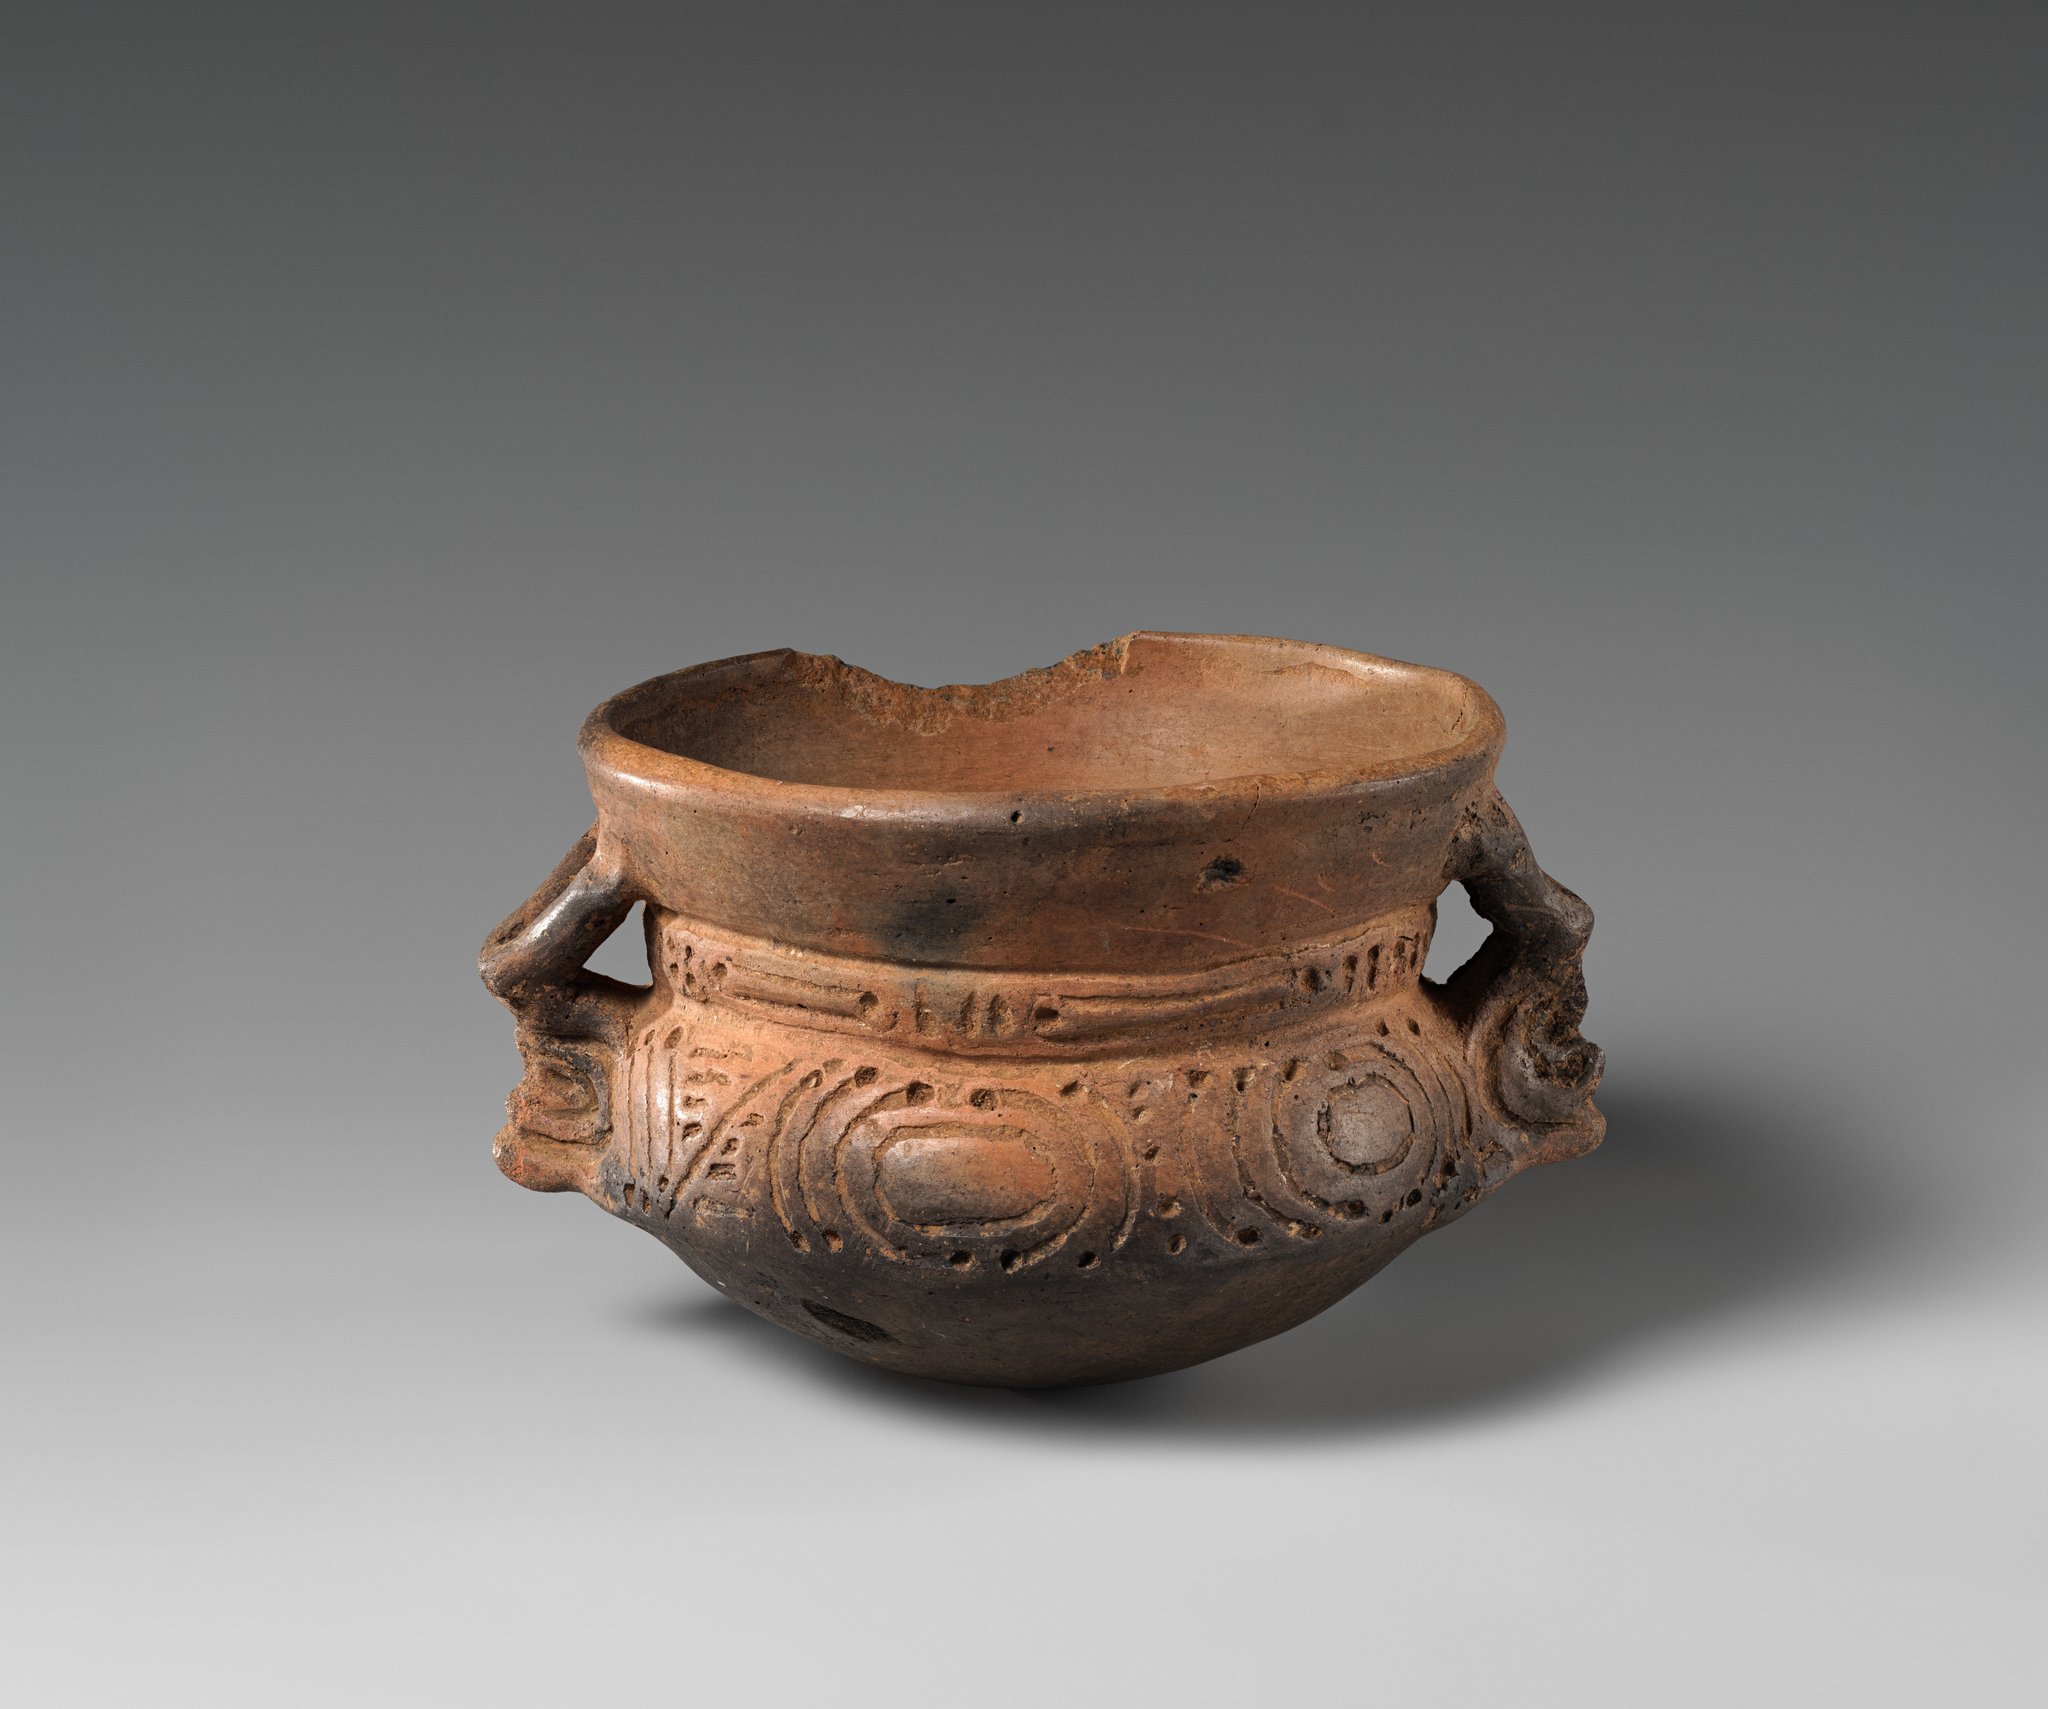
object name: bowl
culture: taíno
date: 1201-1500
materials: ceramic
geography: dominican republic